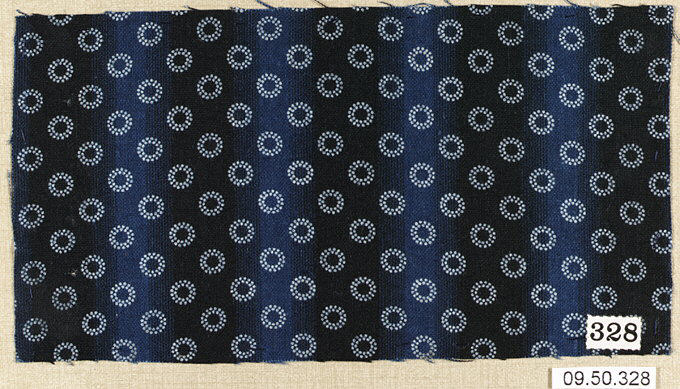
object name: piece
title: Piece (one of 116)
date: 1801-1900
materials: cotton